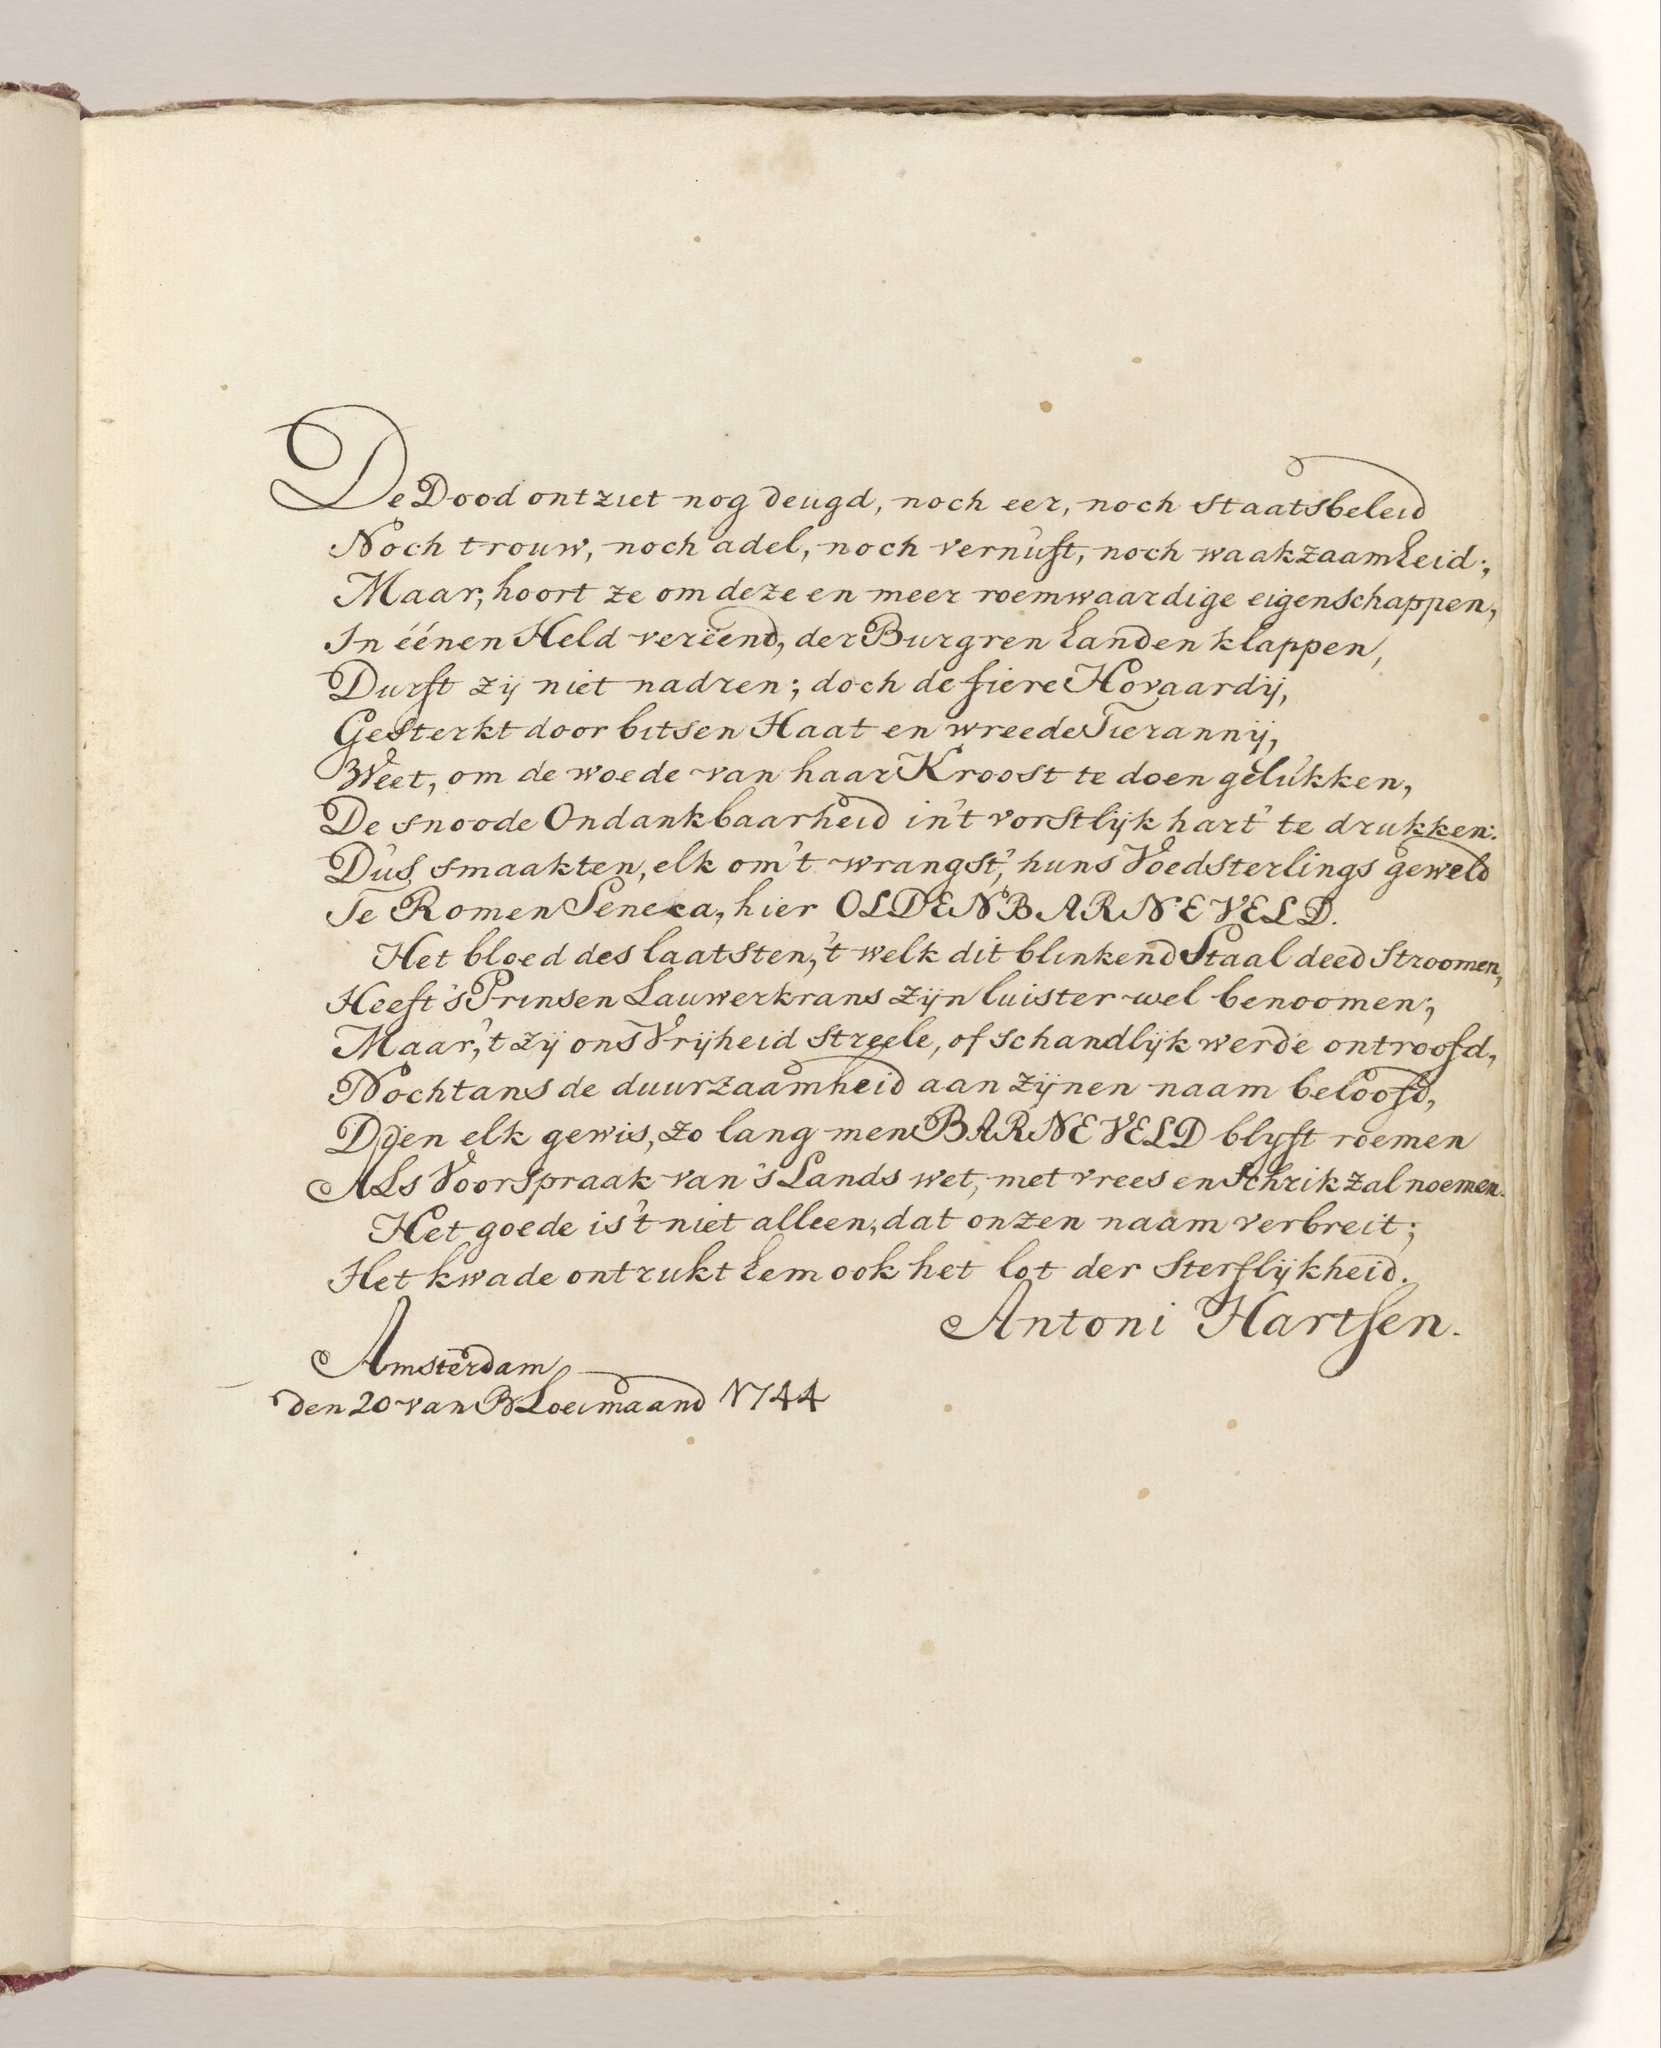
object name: manuscript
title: Gedicht op het zwaard waarmee Johan van Oldenbarnevelt in 1619 zou zijn onthoofd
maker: anthony hartsen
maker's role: koopman, toneelschrijver, vertaler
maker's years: 1719-1782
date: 1744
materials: ink, paper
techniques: writing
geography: amsterdam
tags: johan van oldenbarnevelt, rotterdam, dordrecht, print maker, frans greenwood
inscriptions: date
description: Vers van Anthony Hartsen. Onderdeel van het boek met gedichten uit de jaren 1743-1745 op het zwaard waarmee Johan van Oldenbarnevelt in 1619 zou zijn onthoofd. Het zwaard was eigendom van Frans Greenwood.